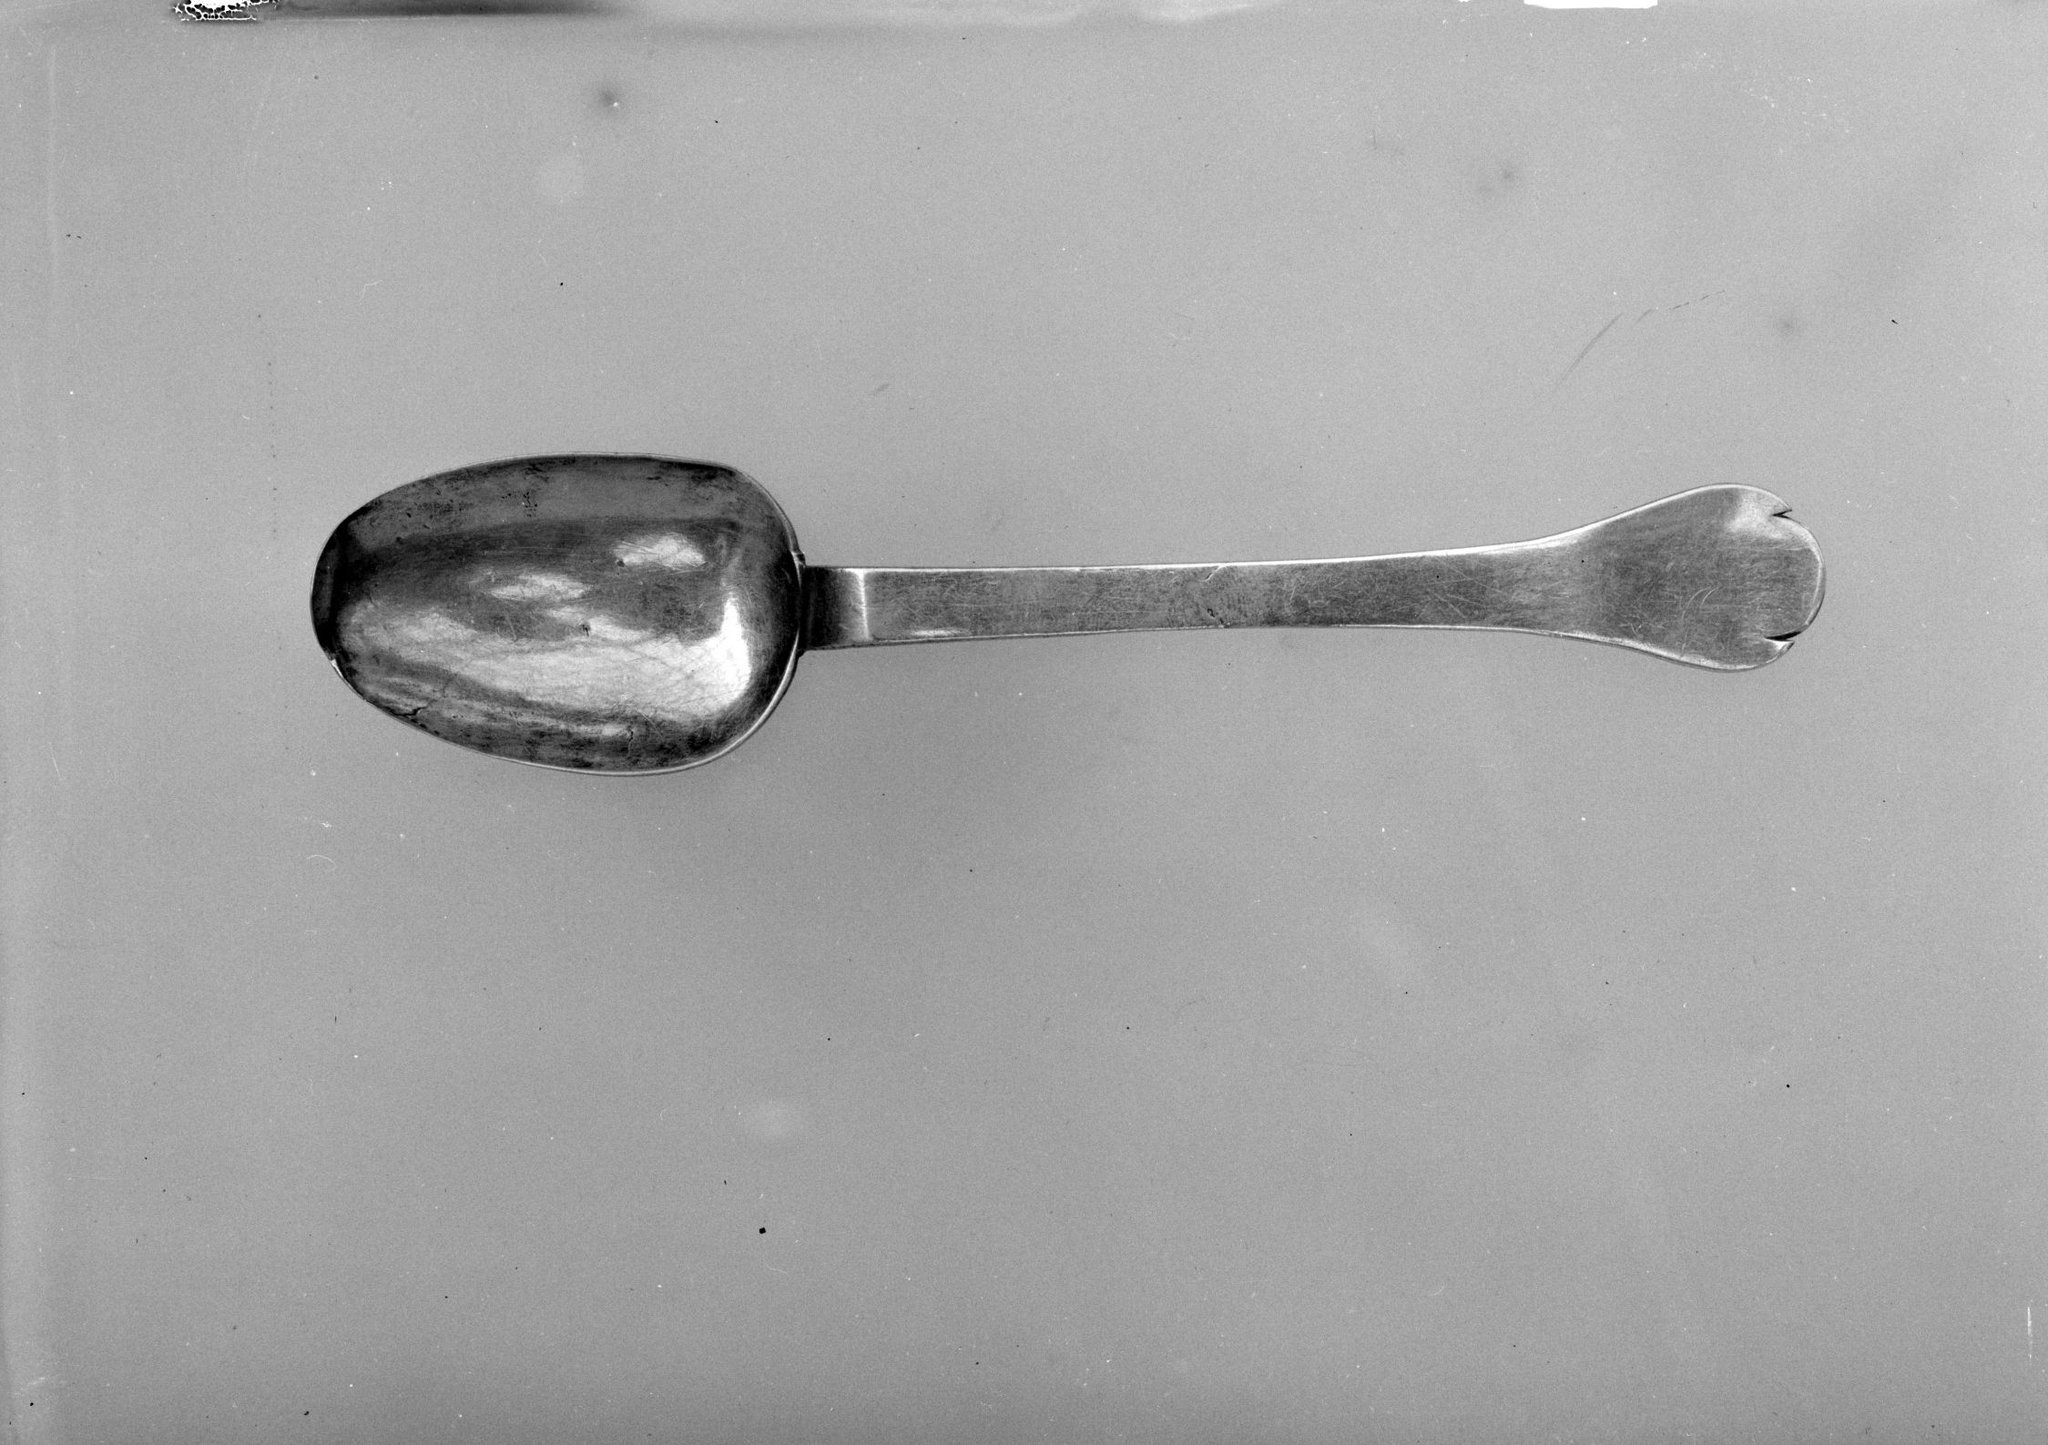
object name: spoon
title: Funeral Spoon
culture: american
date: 1700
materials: silver